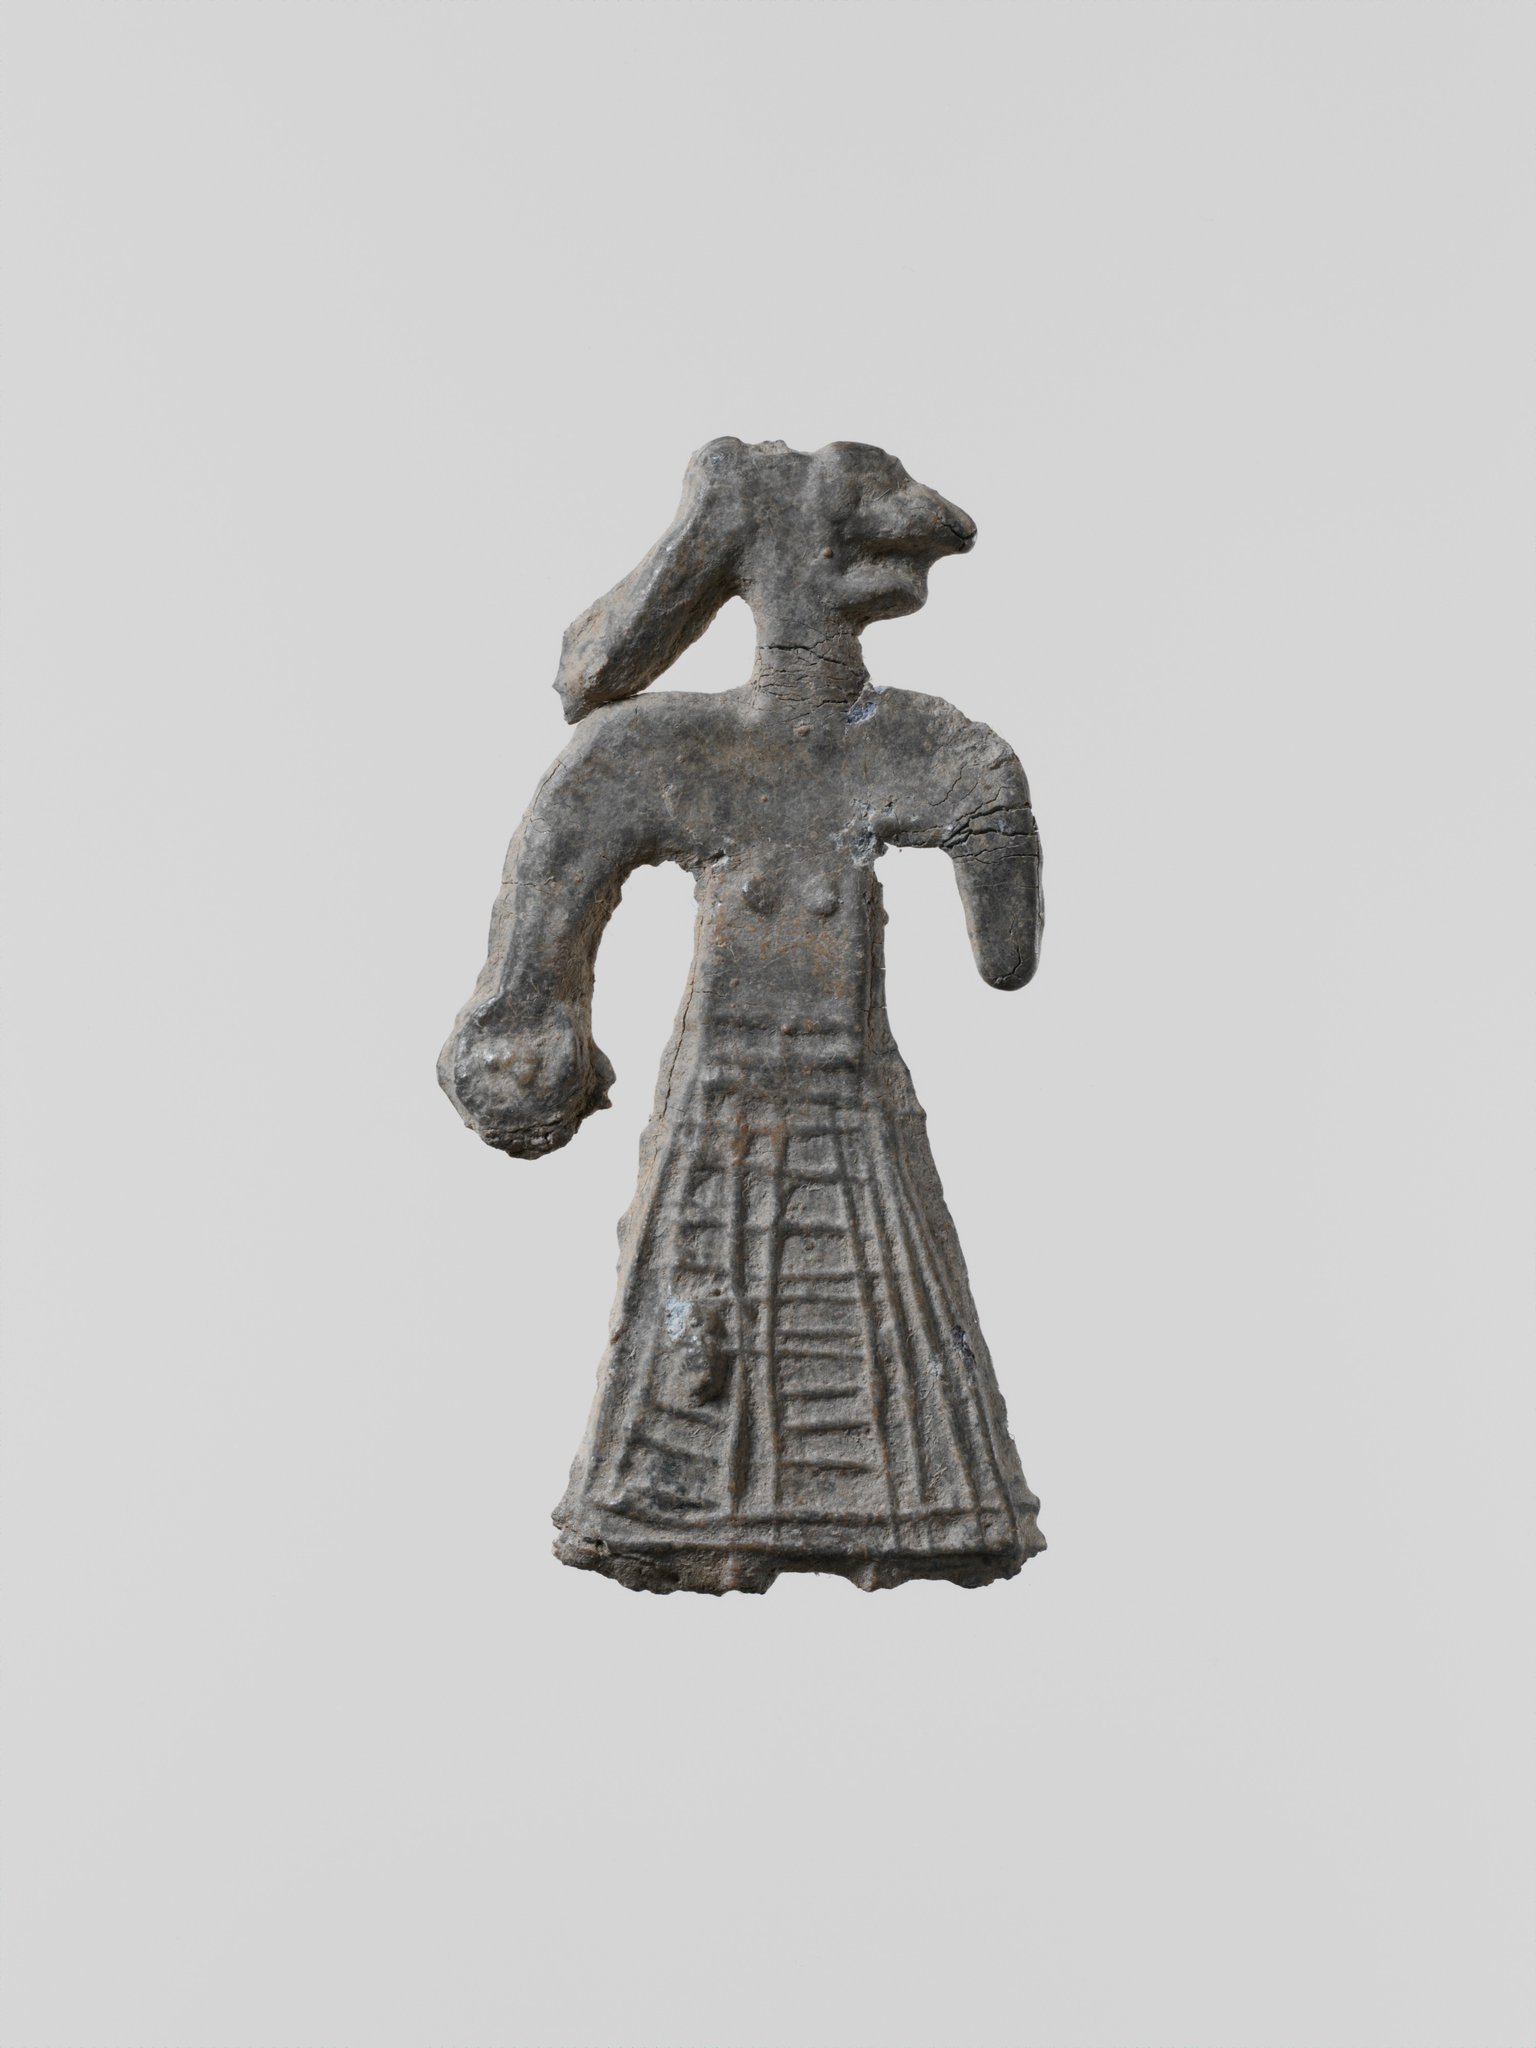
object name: statuette of a woman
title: Lead figure of a woman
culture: greek, laconian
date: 634-501 BCE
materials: lead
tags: women